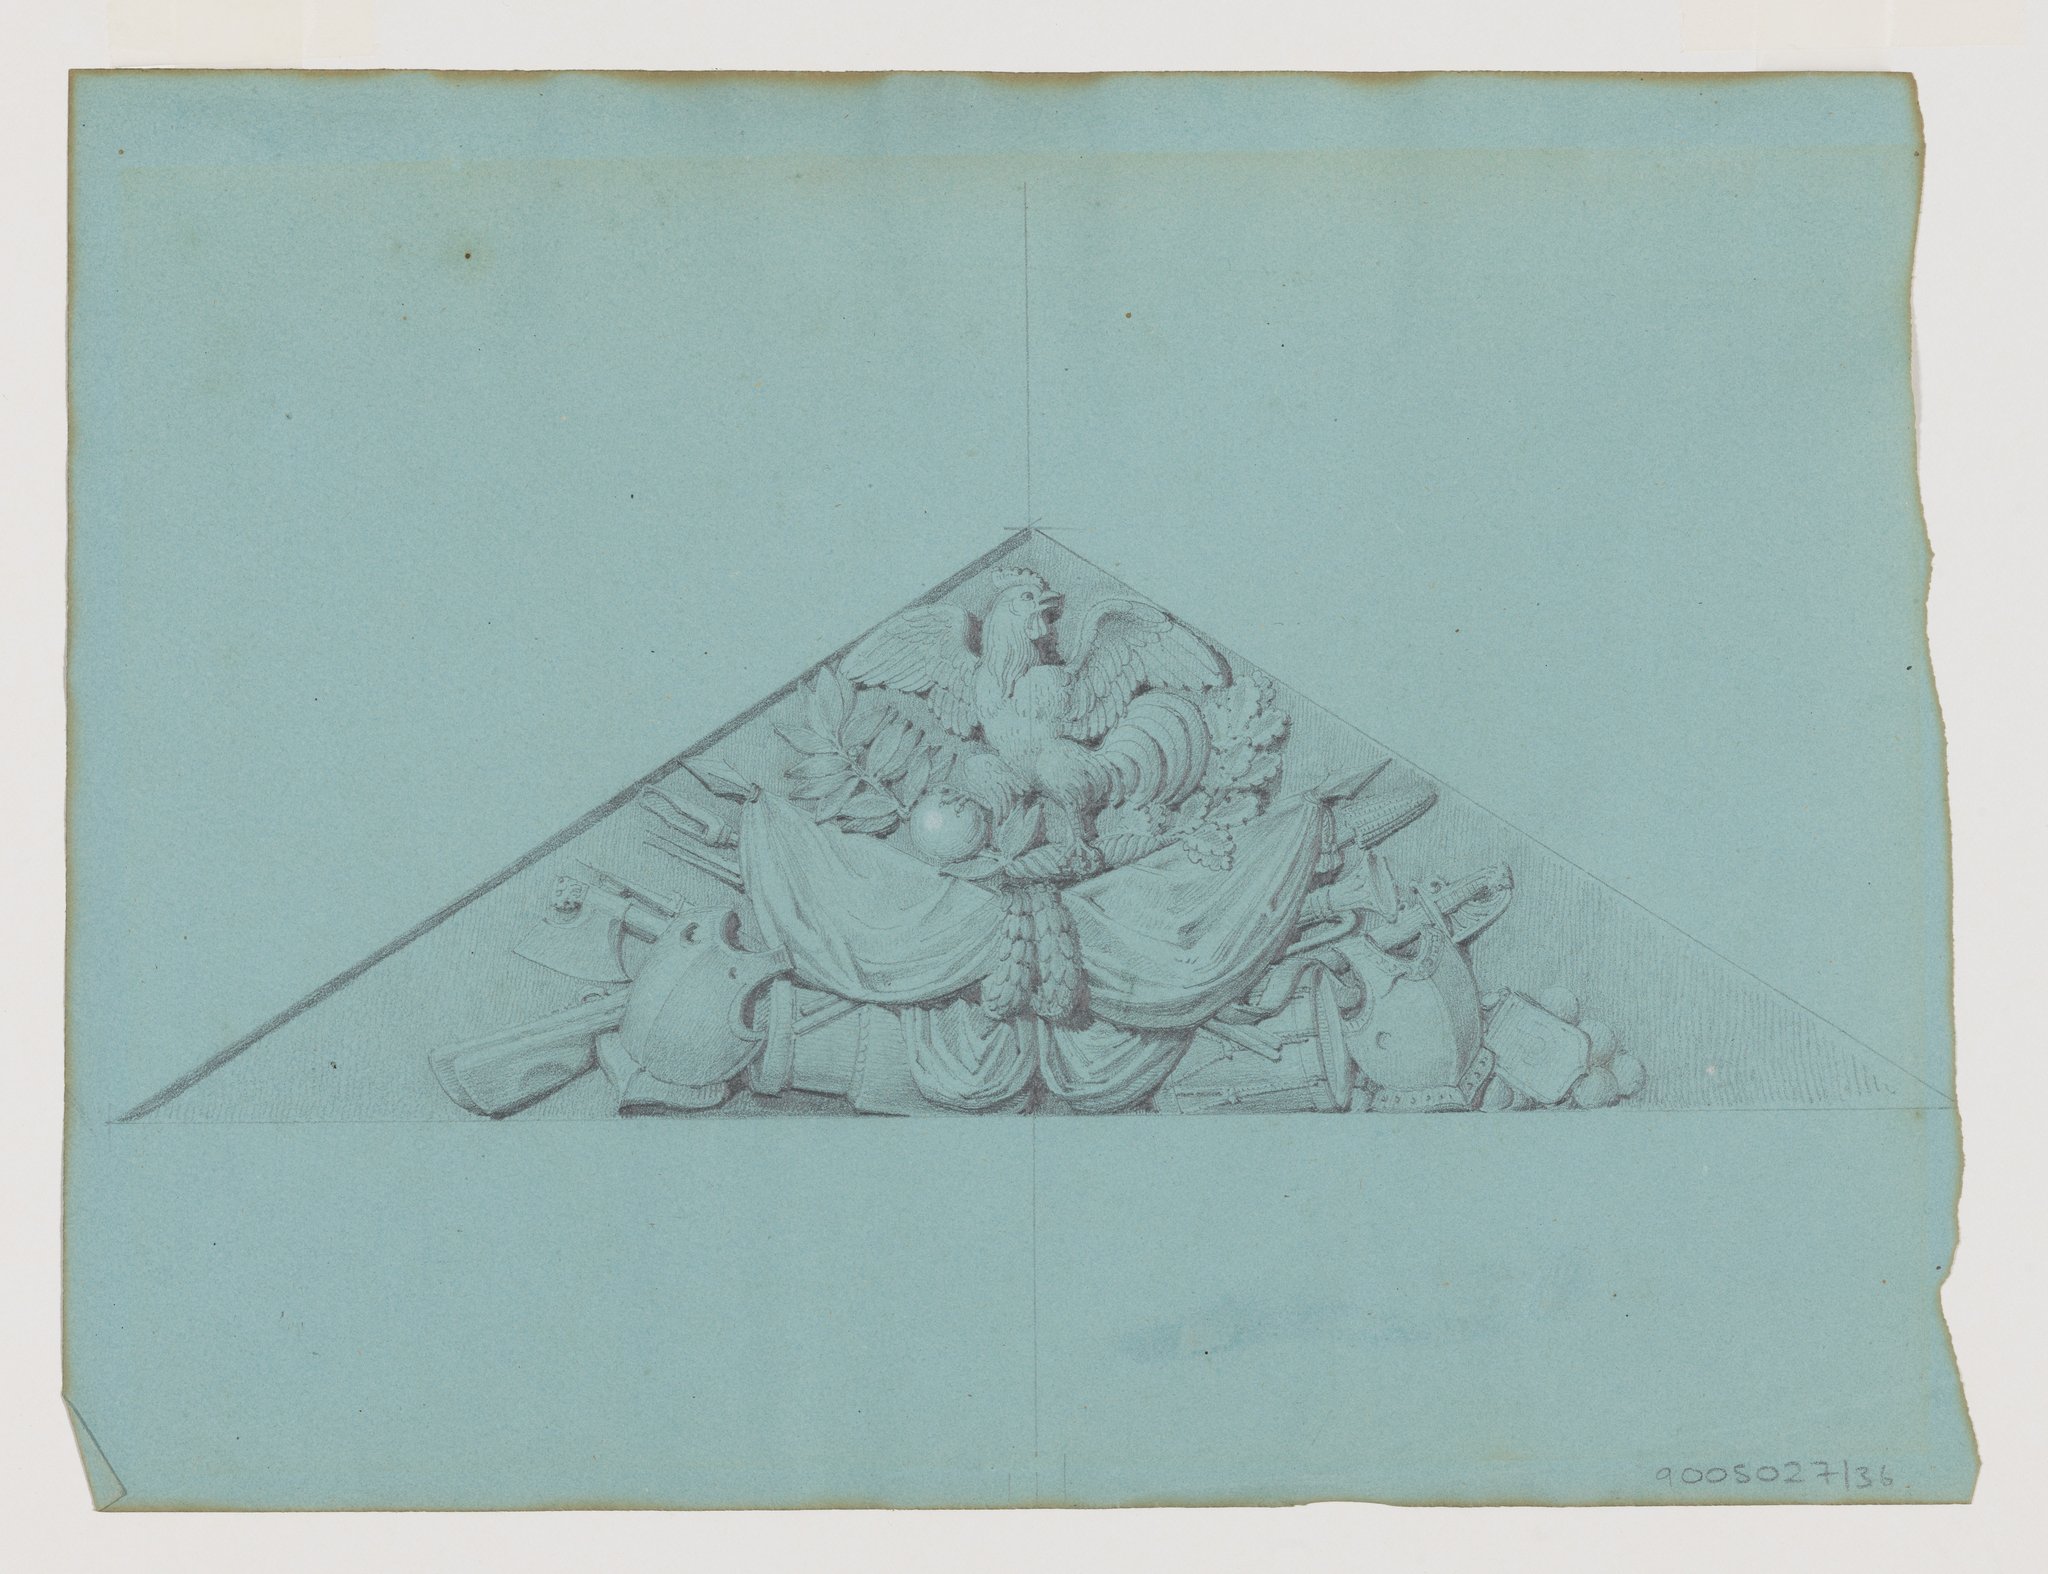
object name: drawing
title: Design for a Pediment with de Coq d’Or on an Armorial Trophy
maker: jean-baptiste louis plantar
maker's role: artist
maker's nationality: french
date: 1834-1866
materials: graphite, ink, watercolor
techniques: pen